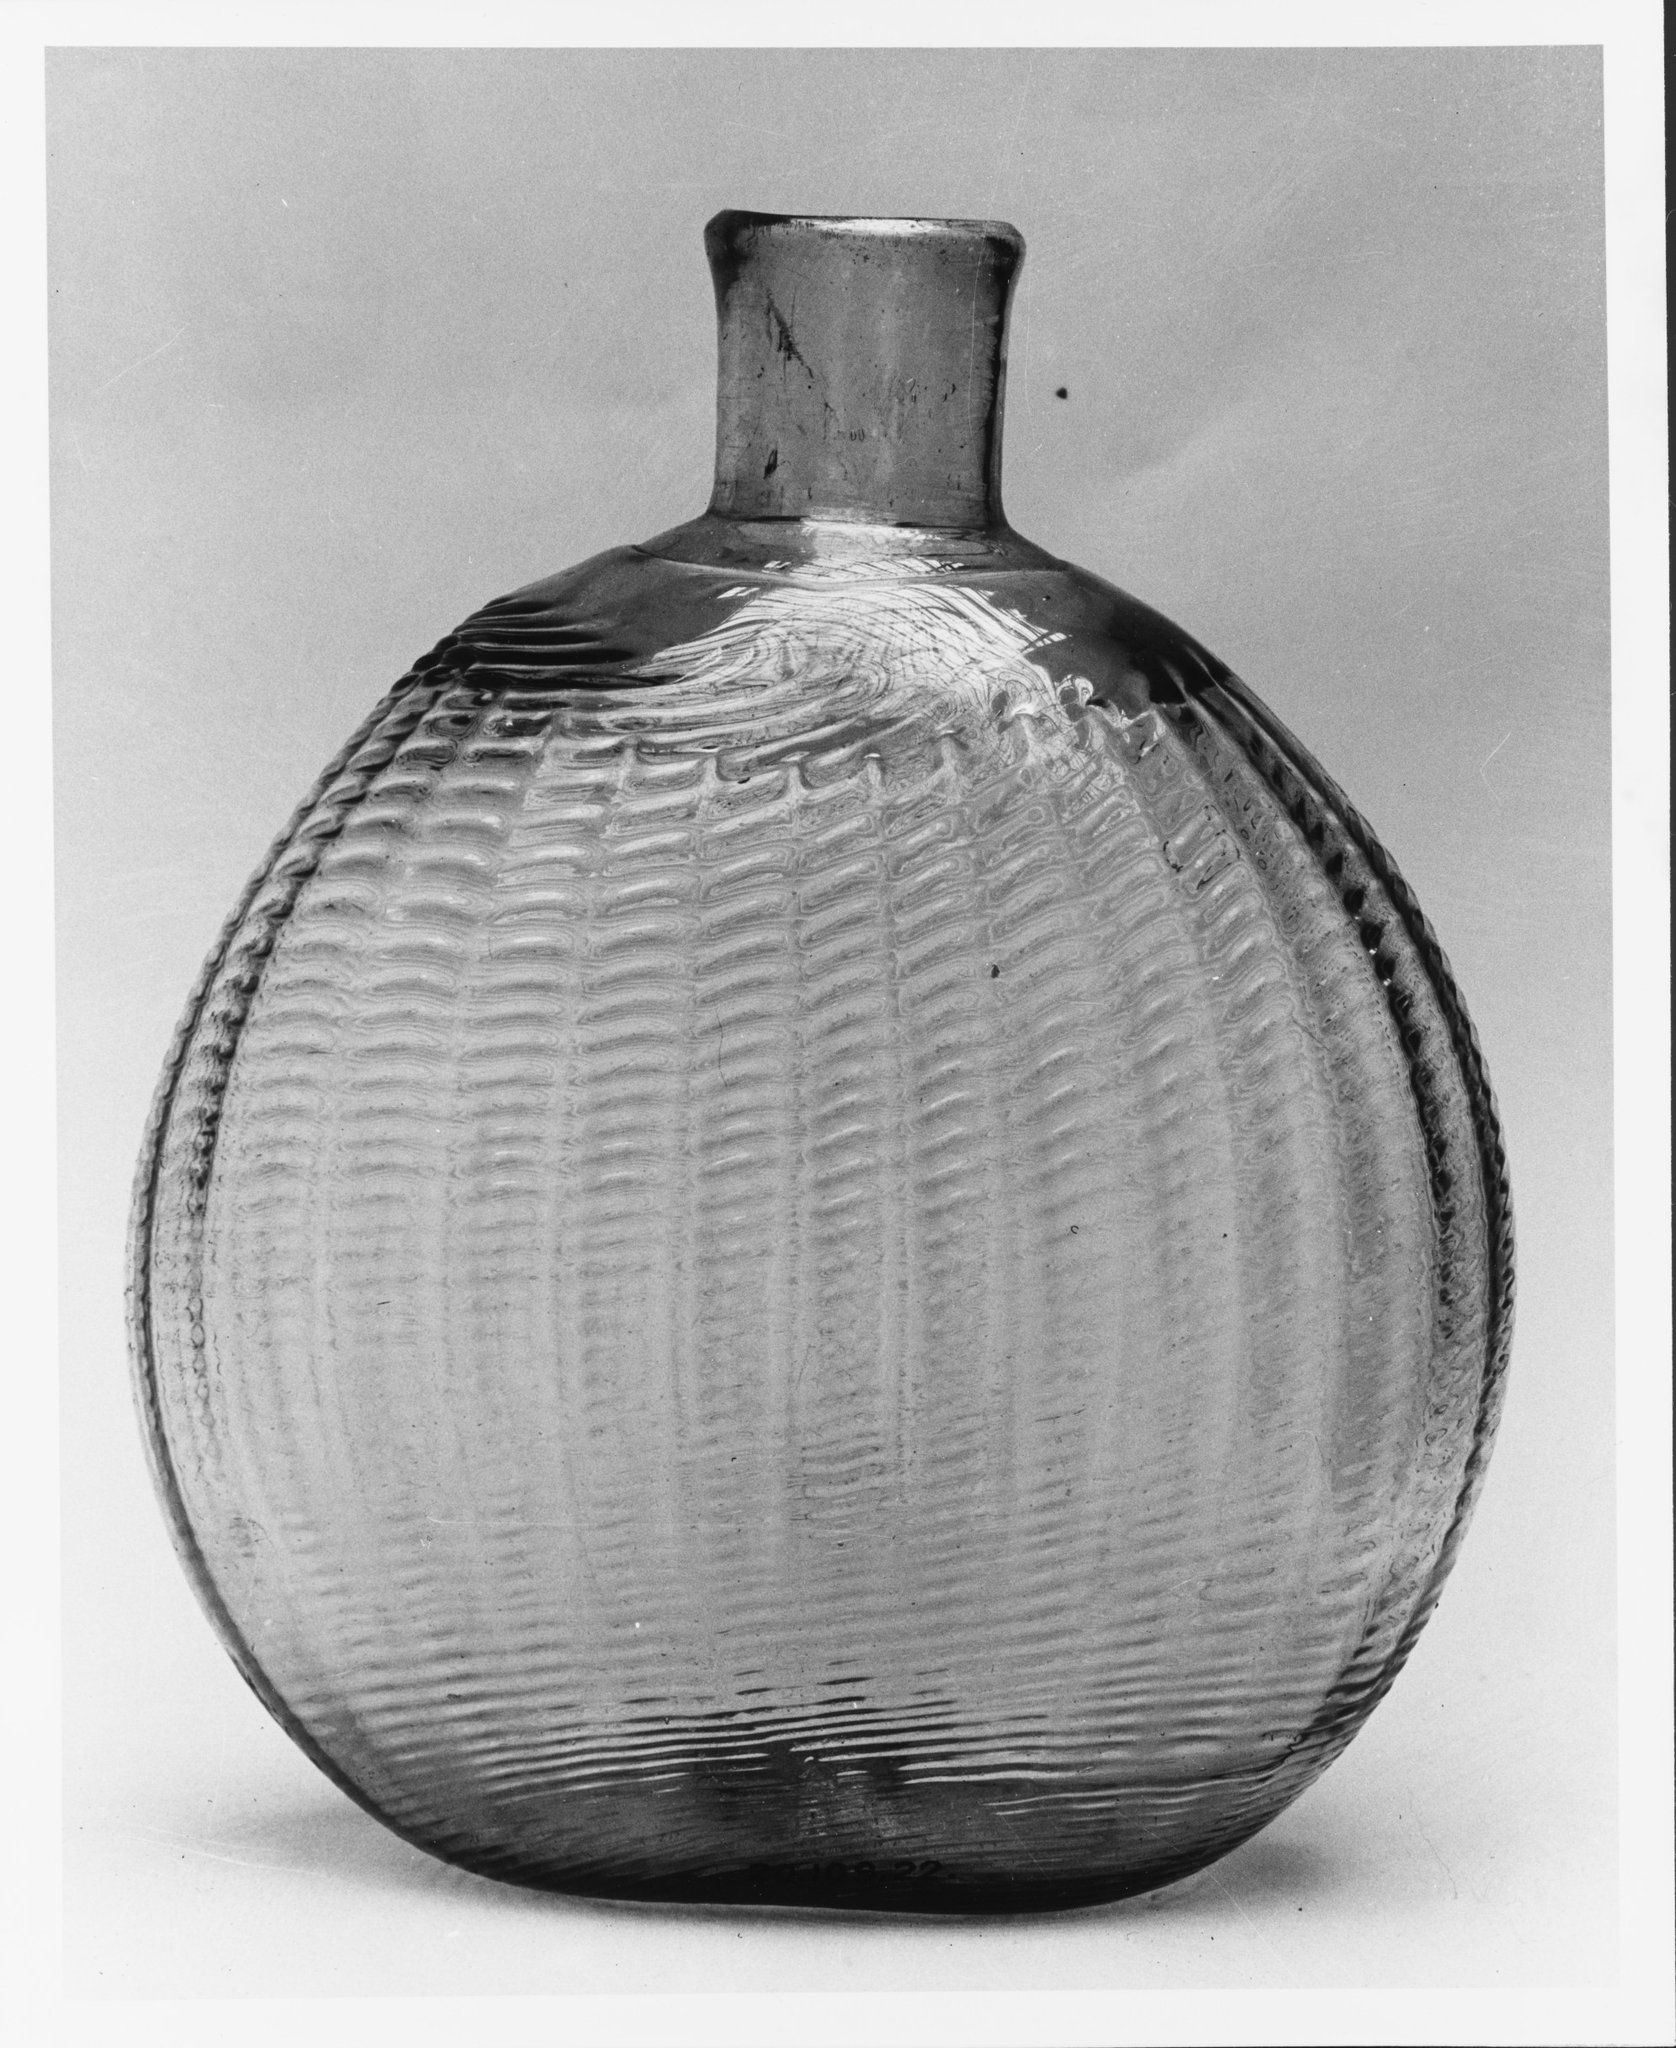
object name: pocket bottle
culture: american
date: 1821-1840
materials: glass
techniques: glassblowing, molding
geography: united states